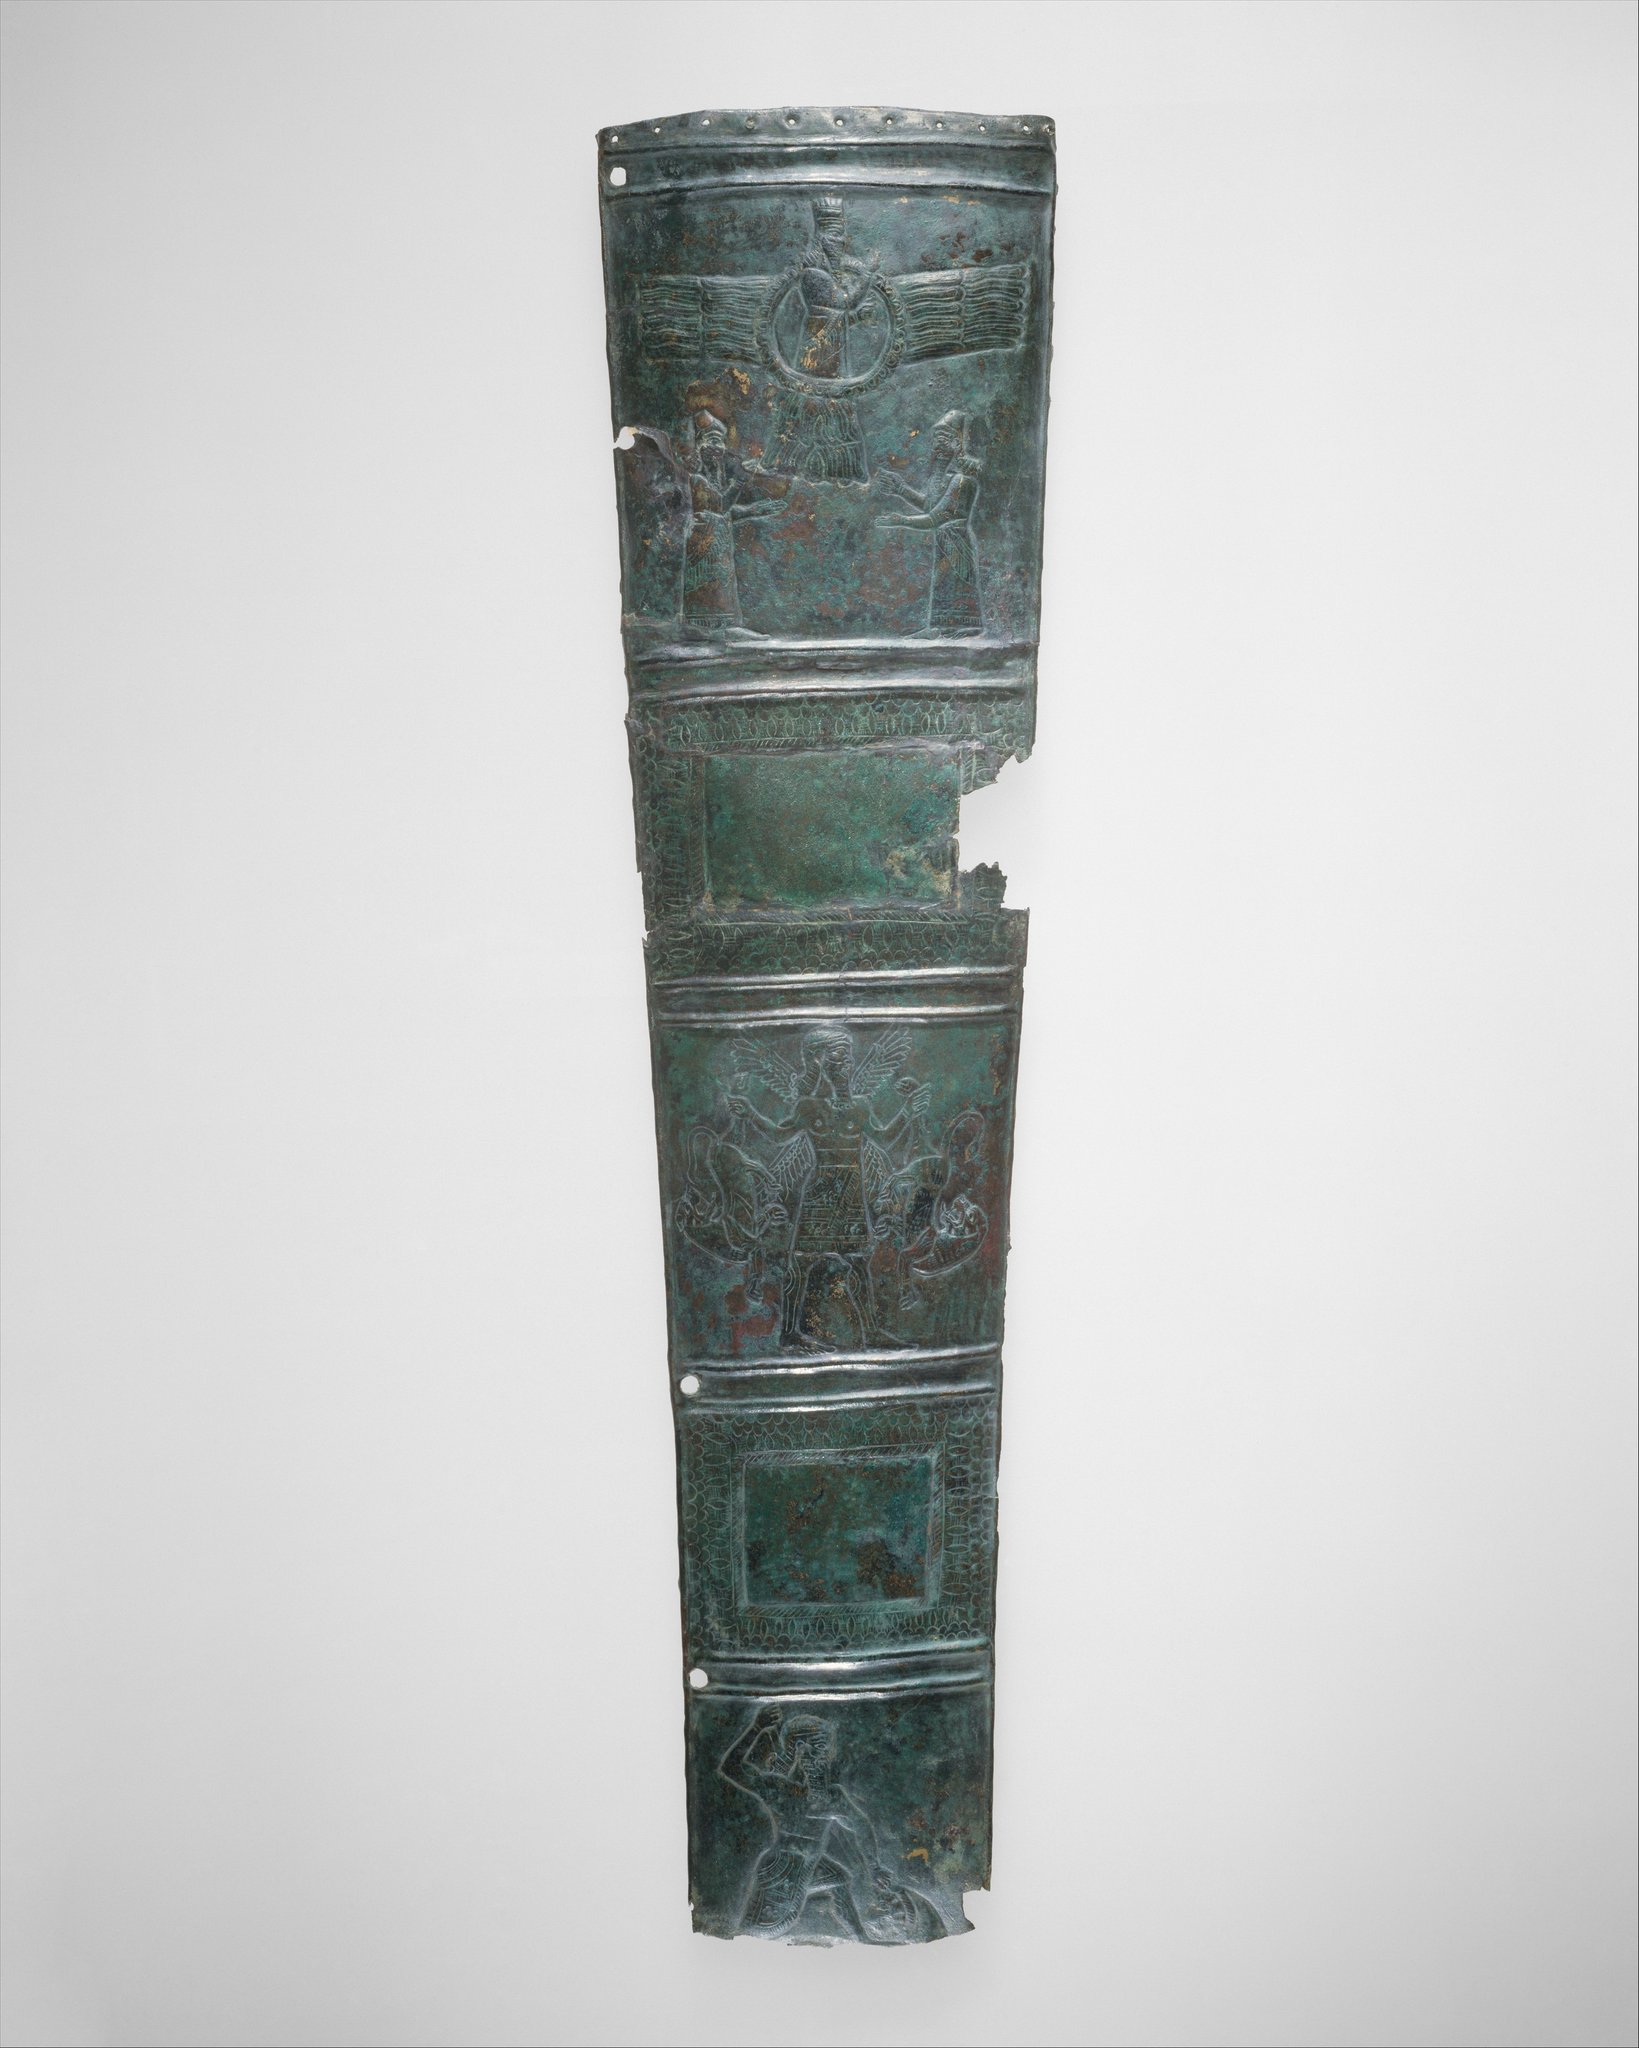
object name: relief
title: Quiver cover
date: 900-701 BCE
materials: bronze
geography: mesopotamia or western iran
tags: animals